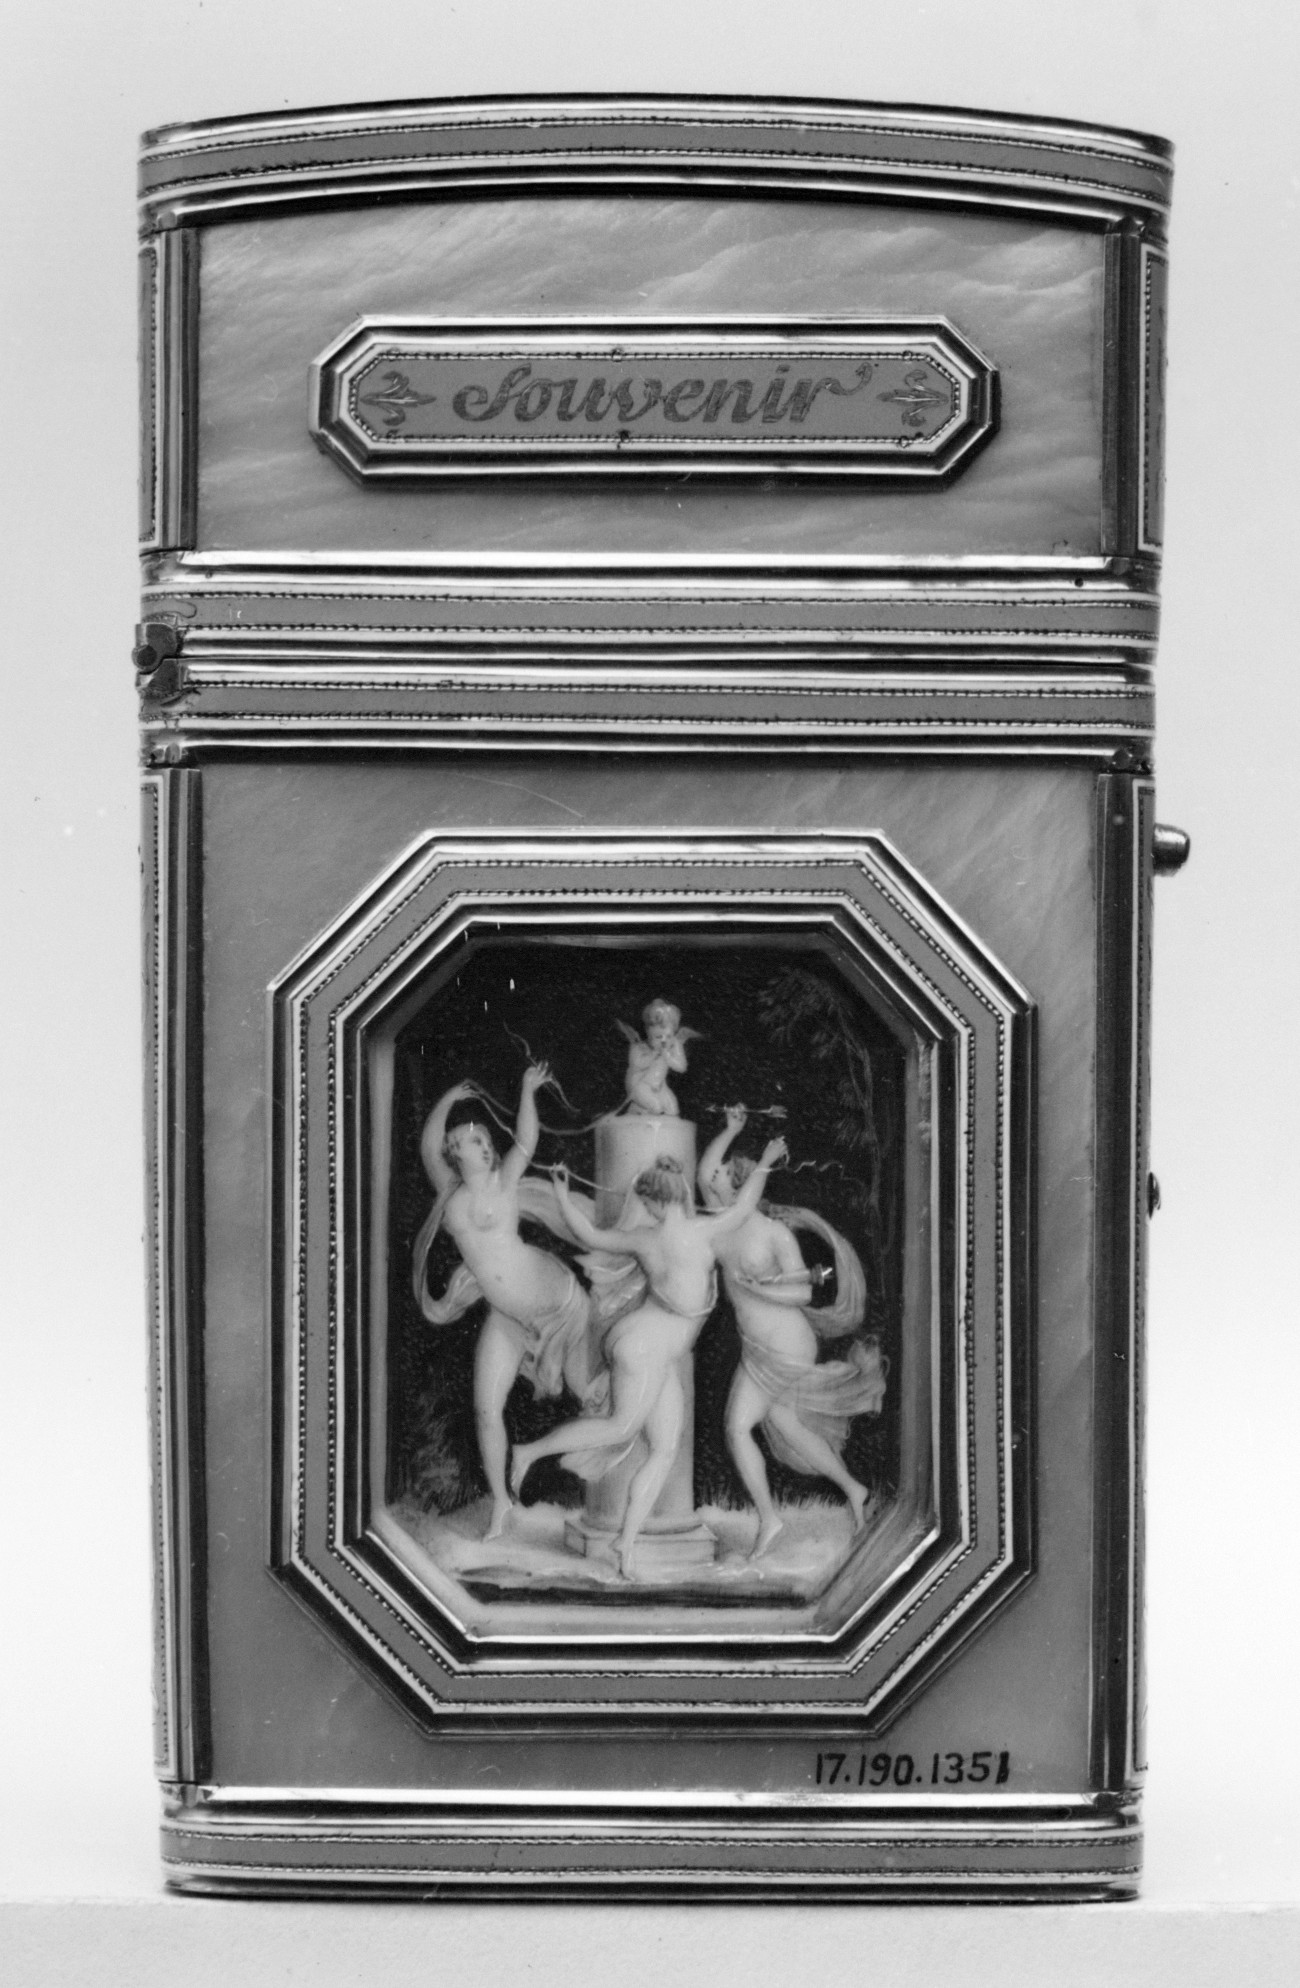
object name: souvenir, painting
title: Souvenir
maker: jacques joseph de gault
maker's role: artist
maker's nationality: french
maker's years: 1738-1812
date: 1789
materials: enamel, gold, ivory, mother of pearl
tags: female nudes,dancing,cupid,angels